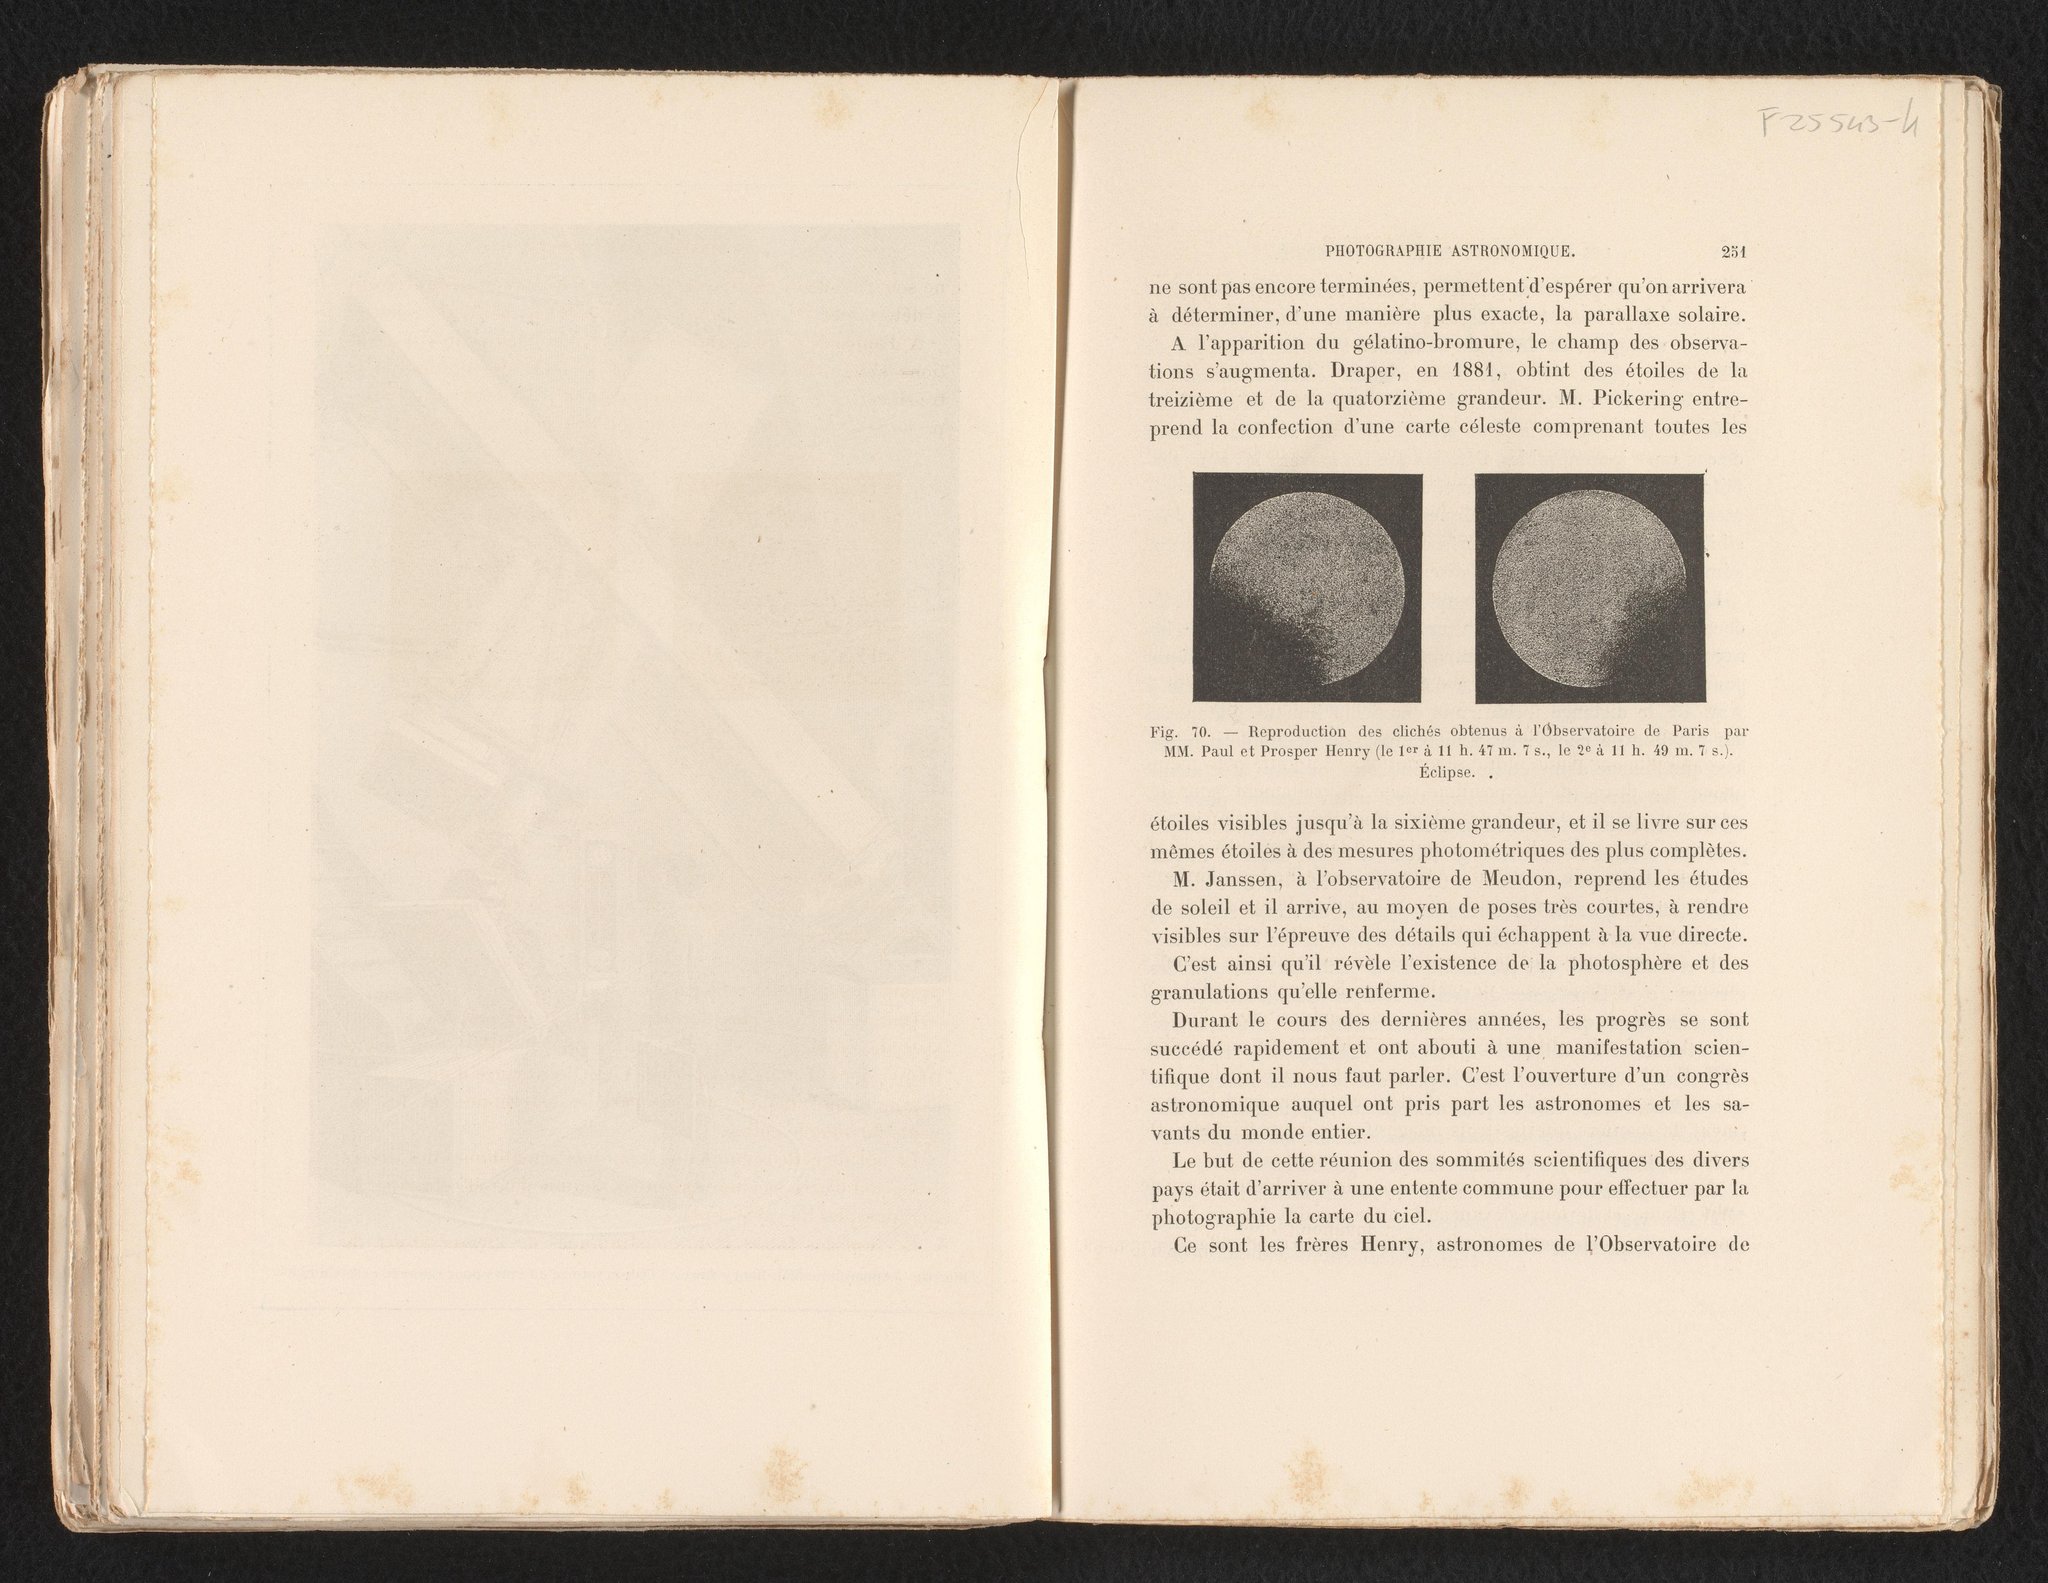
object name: photomechanical print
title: Gedeeltelijke zons- of maansverduistering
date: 1883-1886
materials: paper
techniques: collo-autotype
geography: paris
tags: eclipse of the moon, solar eclipse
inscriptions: number: ‘Fig. 70.’, inscription: ‘Reproduction des clichés obtenus a l'Observatoire de Paris, par/ M.M. Paul et Prosper Henry (le 1er à 11 h. 47 m. 7s., le 2e à 11h. 49m 7s.).’